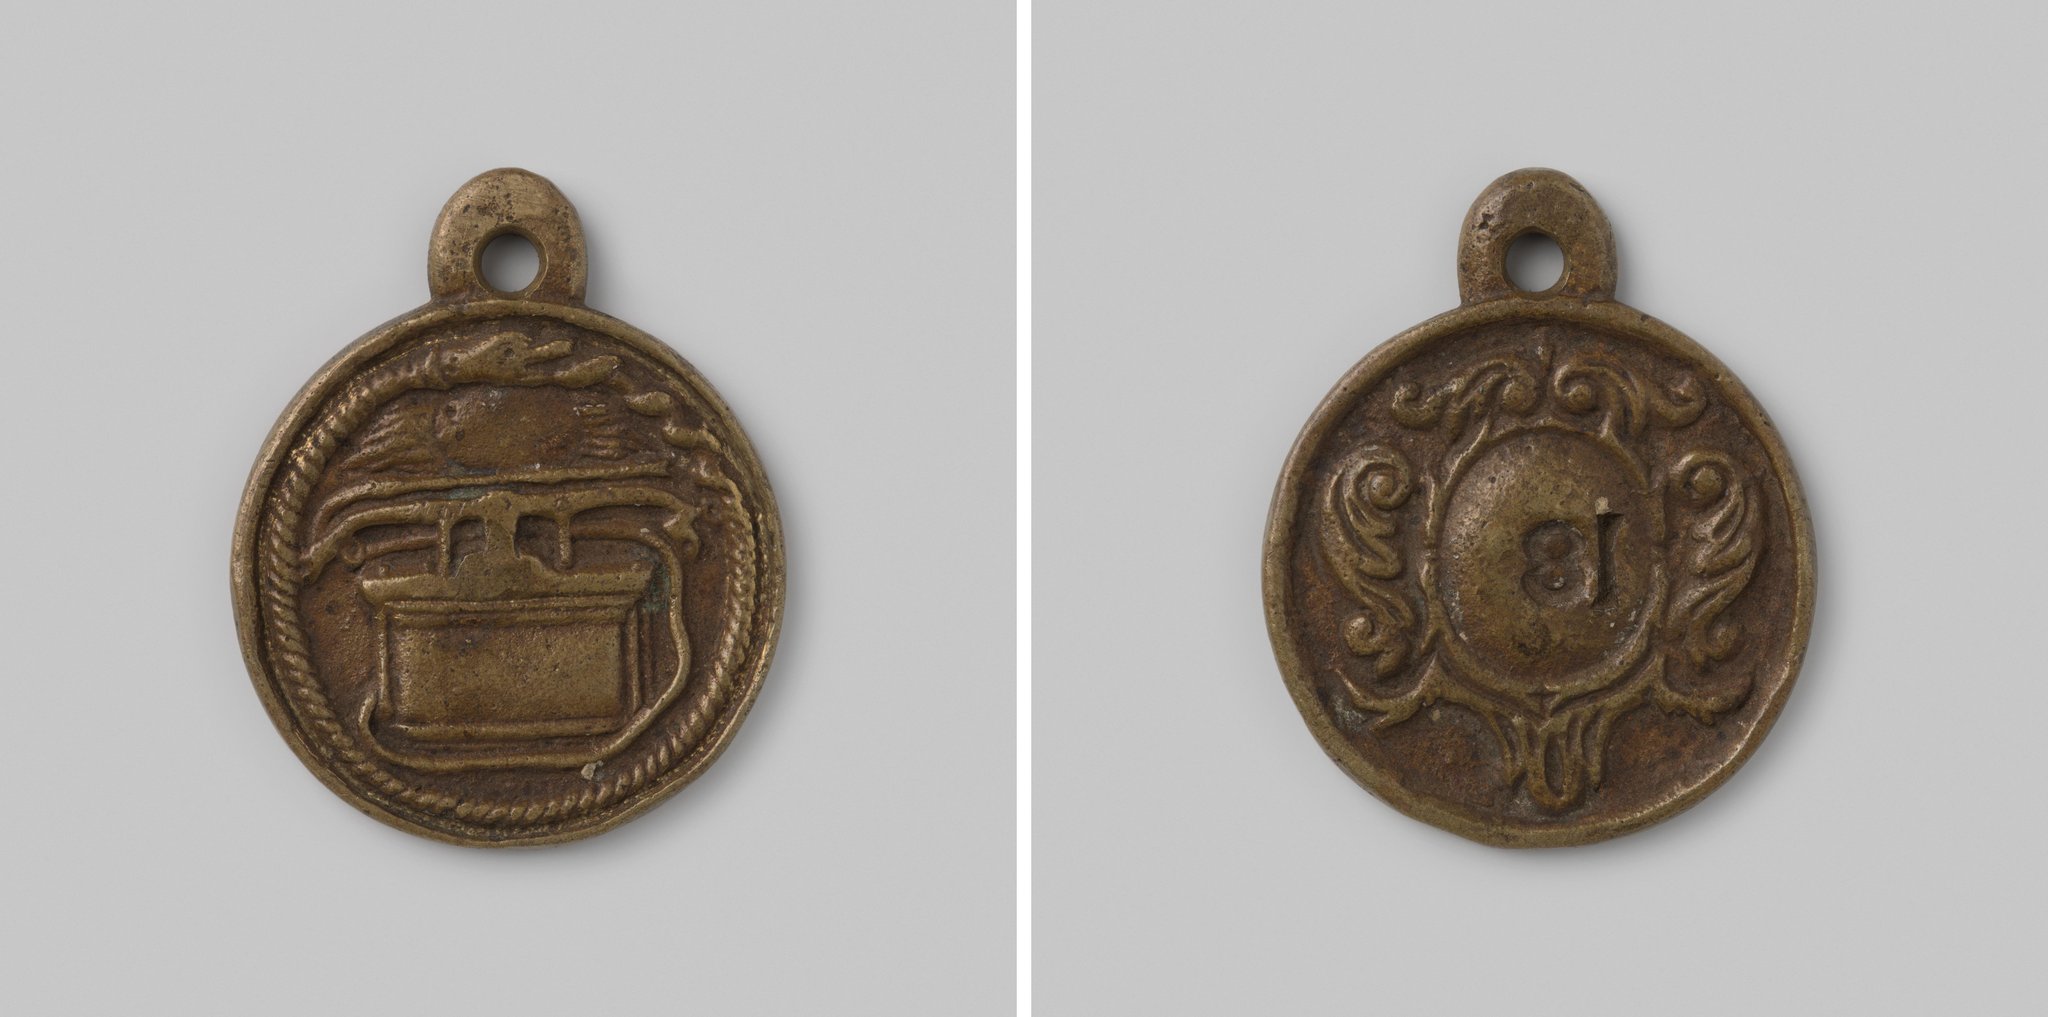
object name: fire engine medal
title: Brandspuitpenning van onbekende plaats, No 81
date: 1675-1800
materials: brass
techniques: casting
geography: netherlands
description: Gegoten messing penning met draagoog, op de voorzijde een brandspuit waarboven een lege cartouche binnen een slangenrond, op de keerzijde tussen bladversieringen een cartouche met ingeslagen nummer "81" ("18"?)